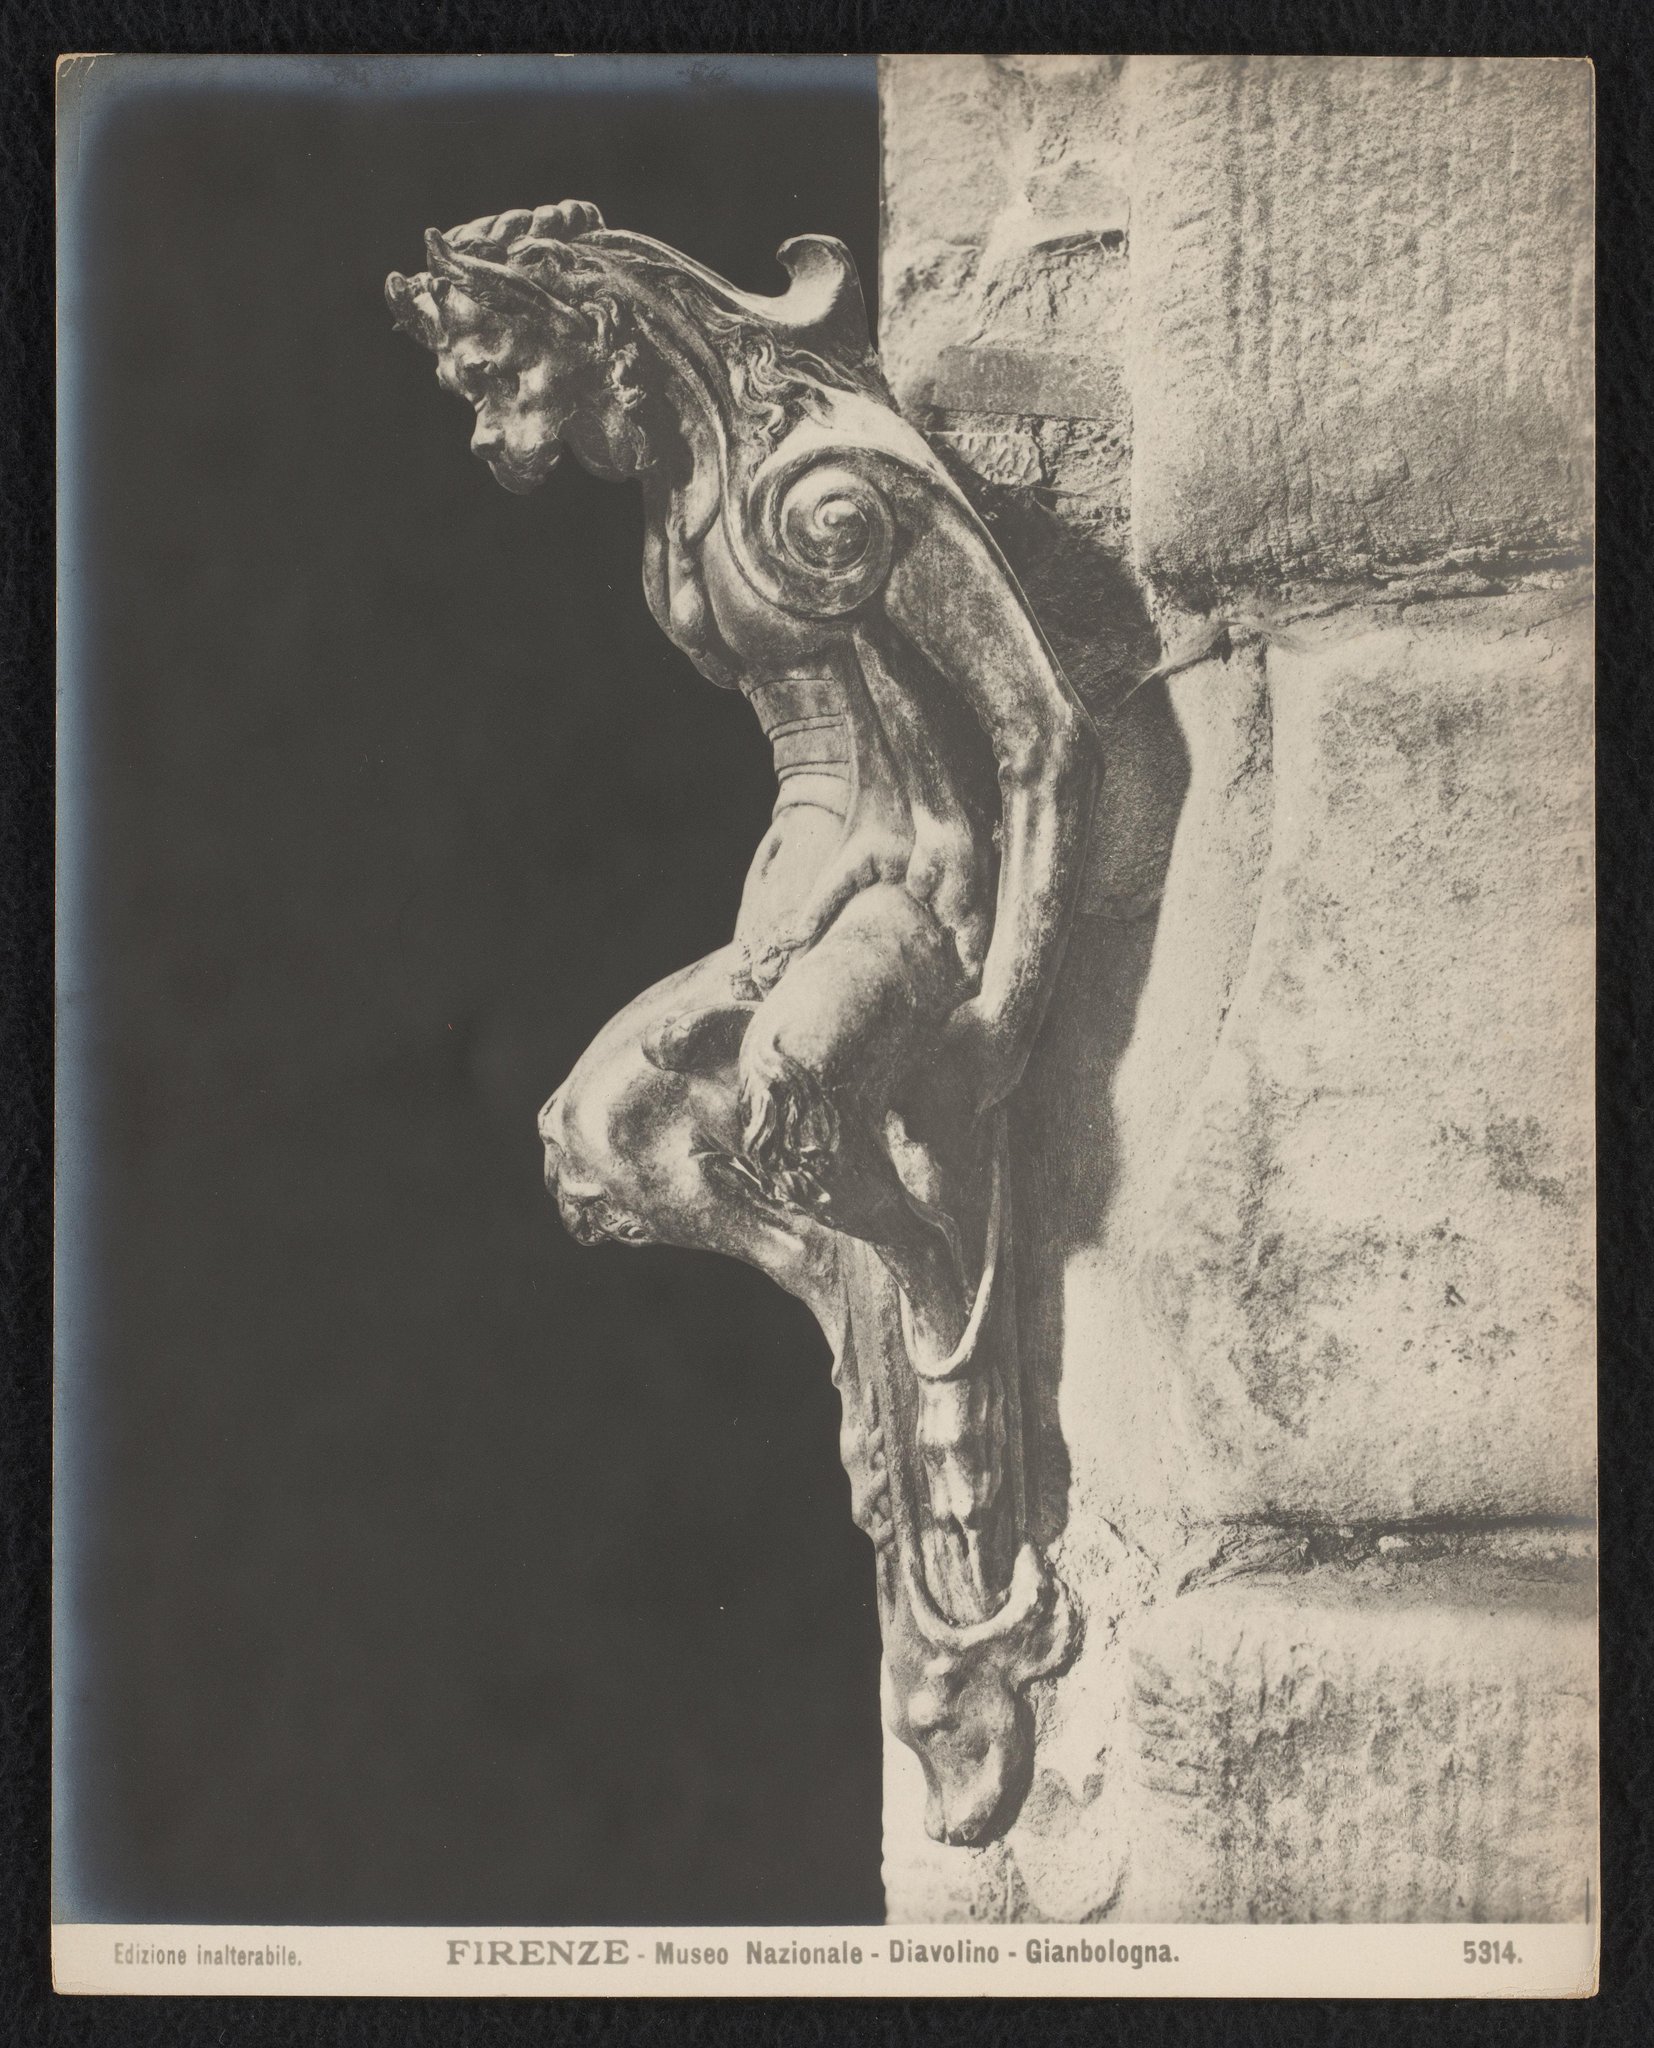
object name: photograph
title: Museo Nazionale - Diavolino - Gianbologna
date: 1901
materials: paper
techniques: gelatin silver print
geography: berlin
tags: piece of sculpture, reproduction of a piece of sculpture, satyr(s) (in general)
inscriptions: number: ‘5314.’, inscription: ‘Edizione inalterabile.’, collector's mark: ‘RIJKS SCHOOL VOOR KUNSTNIJVERHEID/ GROEP’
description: Deze foto maakt deel uit van een omslag.